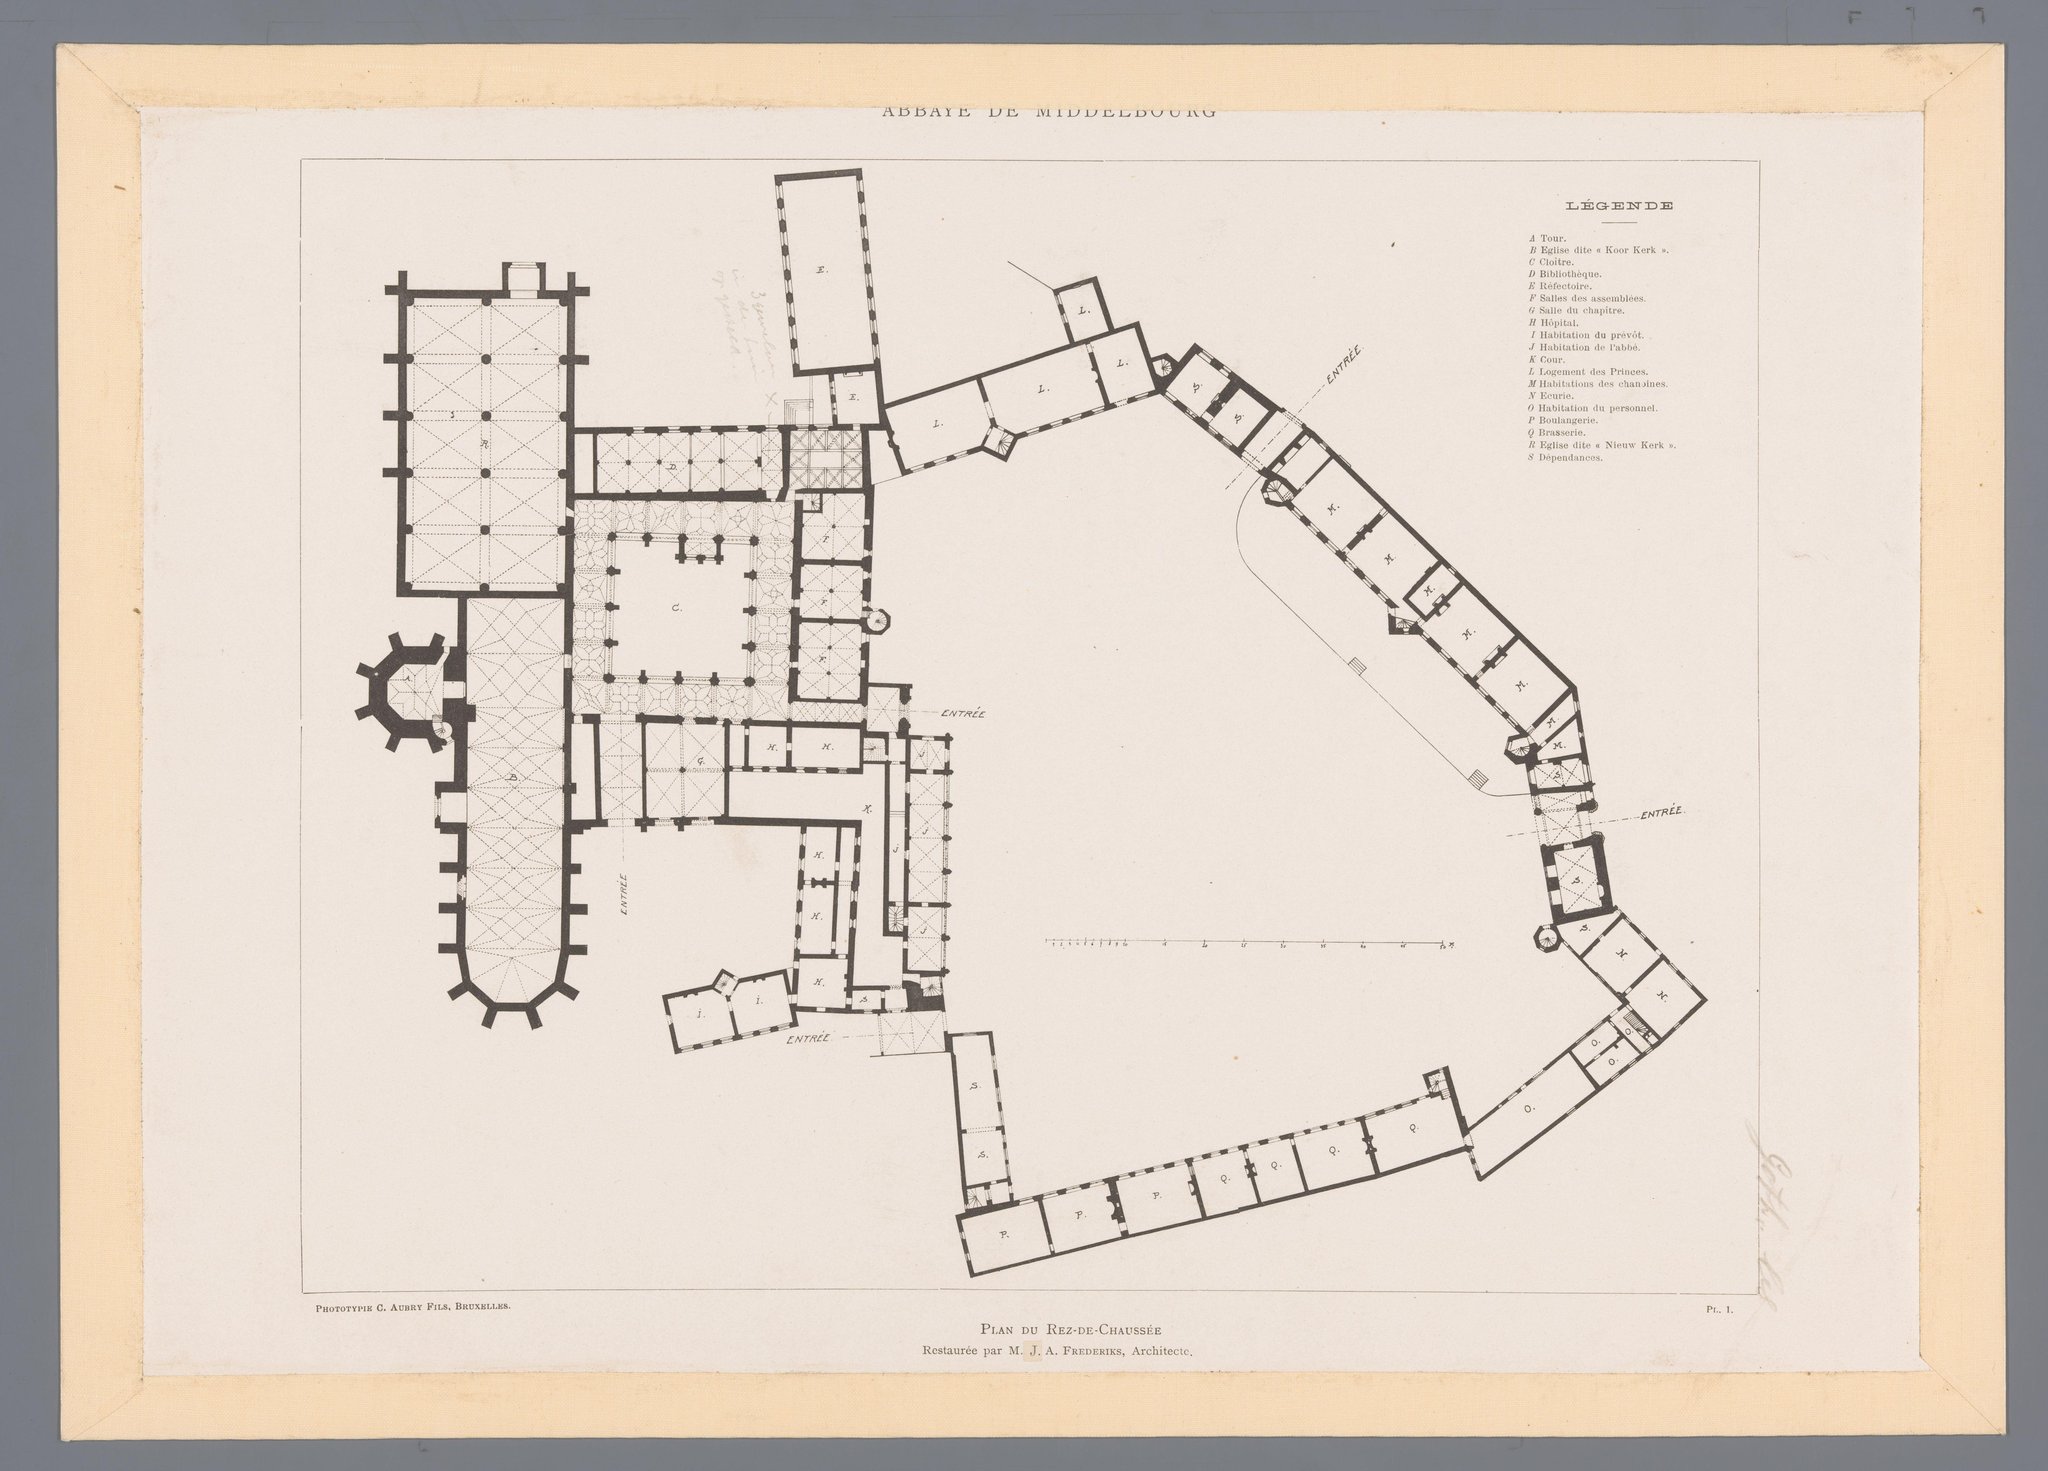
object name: area plan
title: Plan du Rez-de-Chaussée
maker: Anonymous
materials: paper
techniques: photograph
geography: brussels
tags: abbey, monastery, convent ~ roman catholic church